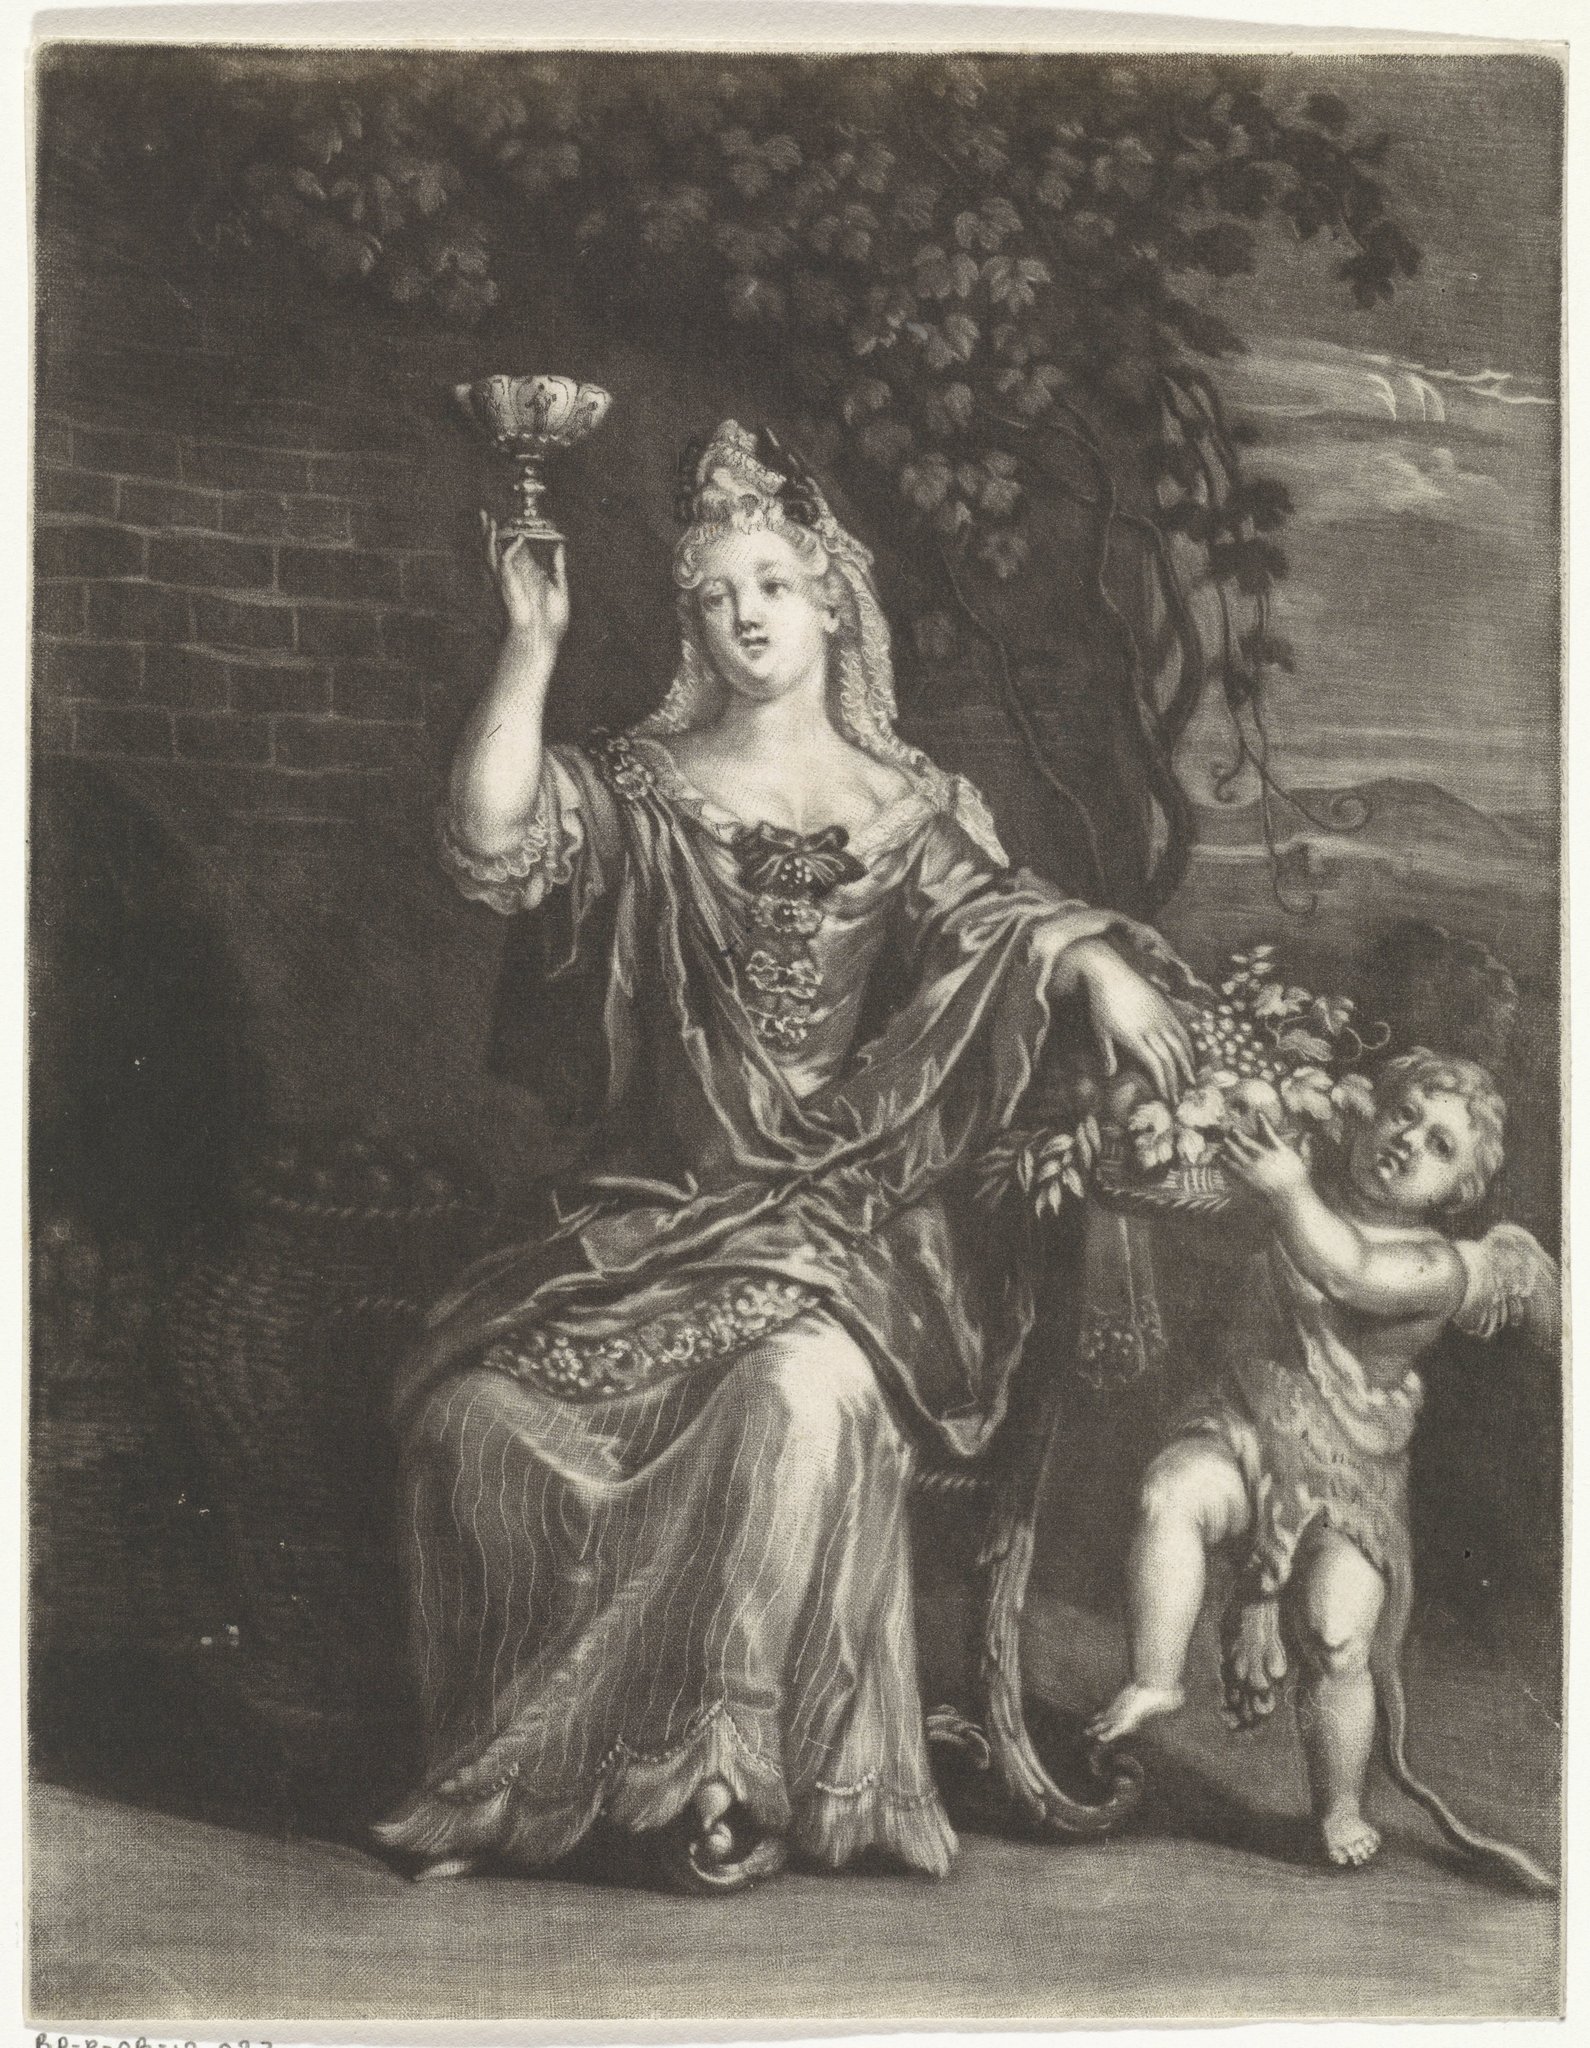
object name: print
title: Herfst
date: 1670-1700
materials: paper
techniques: mezzotint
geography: netherlands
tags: mug, beaker, goblet, fruits, autumn, fall, 'autumnus'; 'autunno' (ripa)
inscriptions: collector's mark: Lugt 2228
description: Allegorische voorstelling van de herfst. Een vrouw houdt een bokaal in de hand en pakt met de andere hand vruchten uit een mand, vastgehouden door een putto. Naast haar staan enkele manden met vruchten. De prent maakt deel uit van een serie van vier prenten met de vier seizoenen.